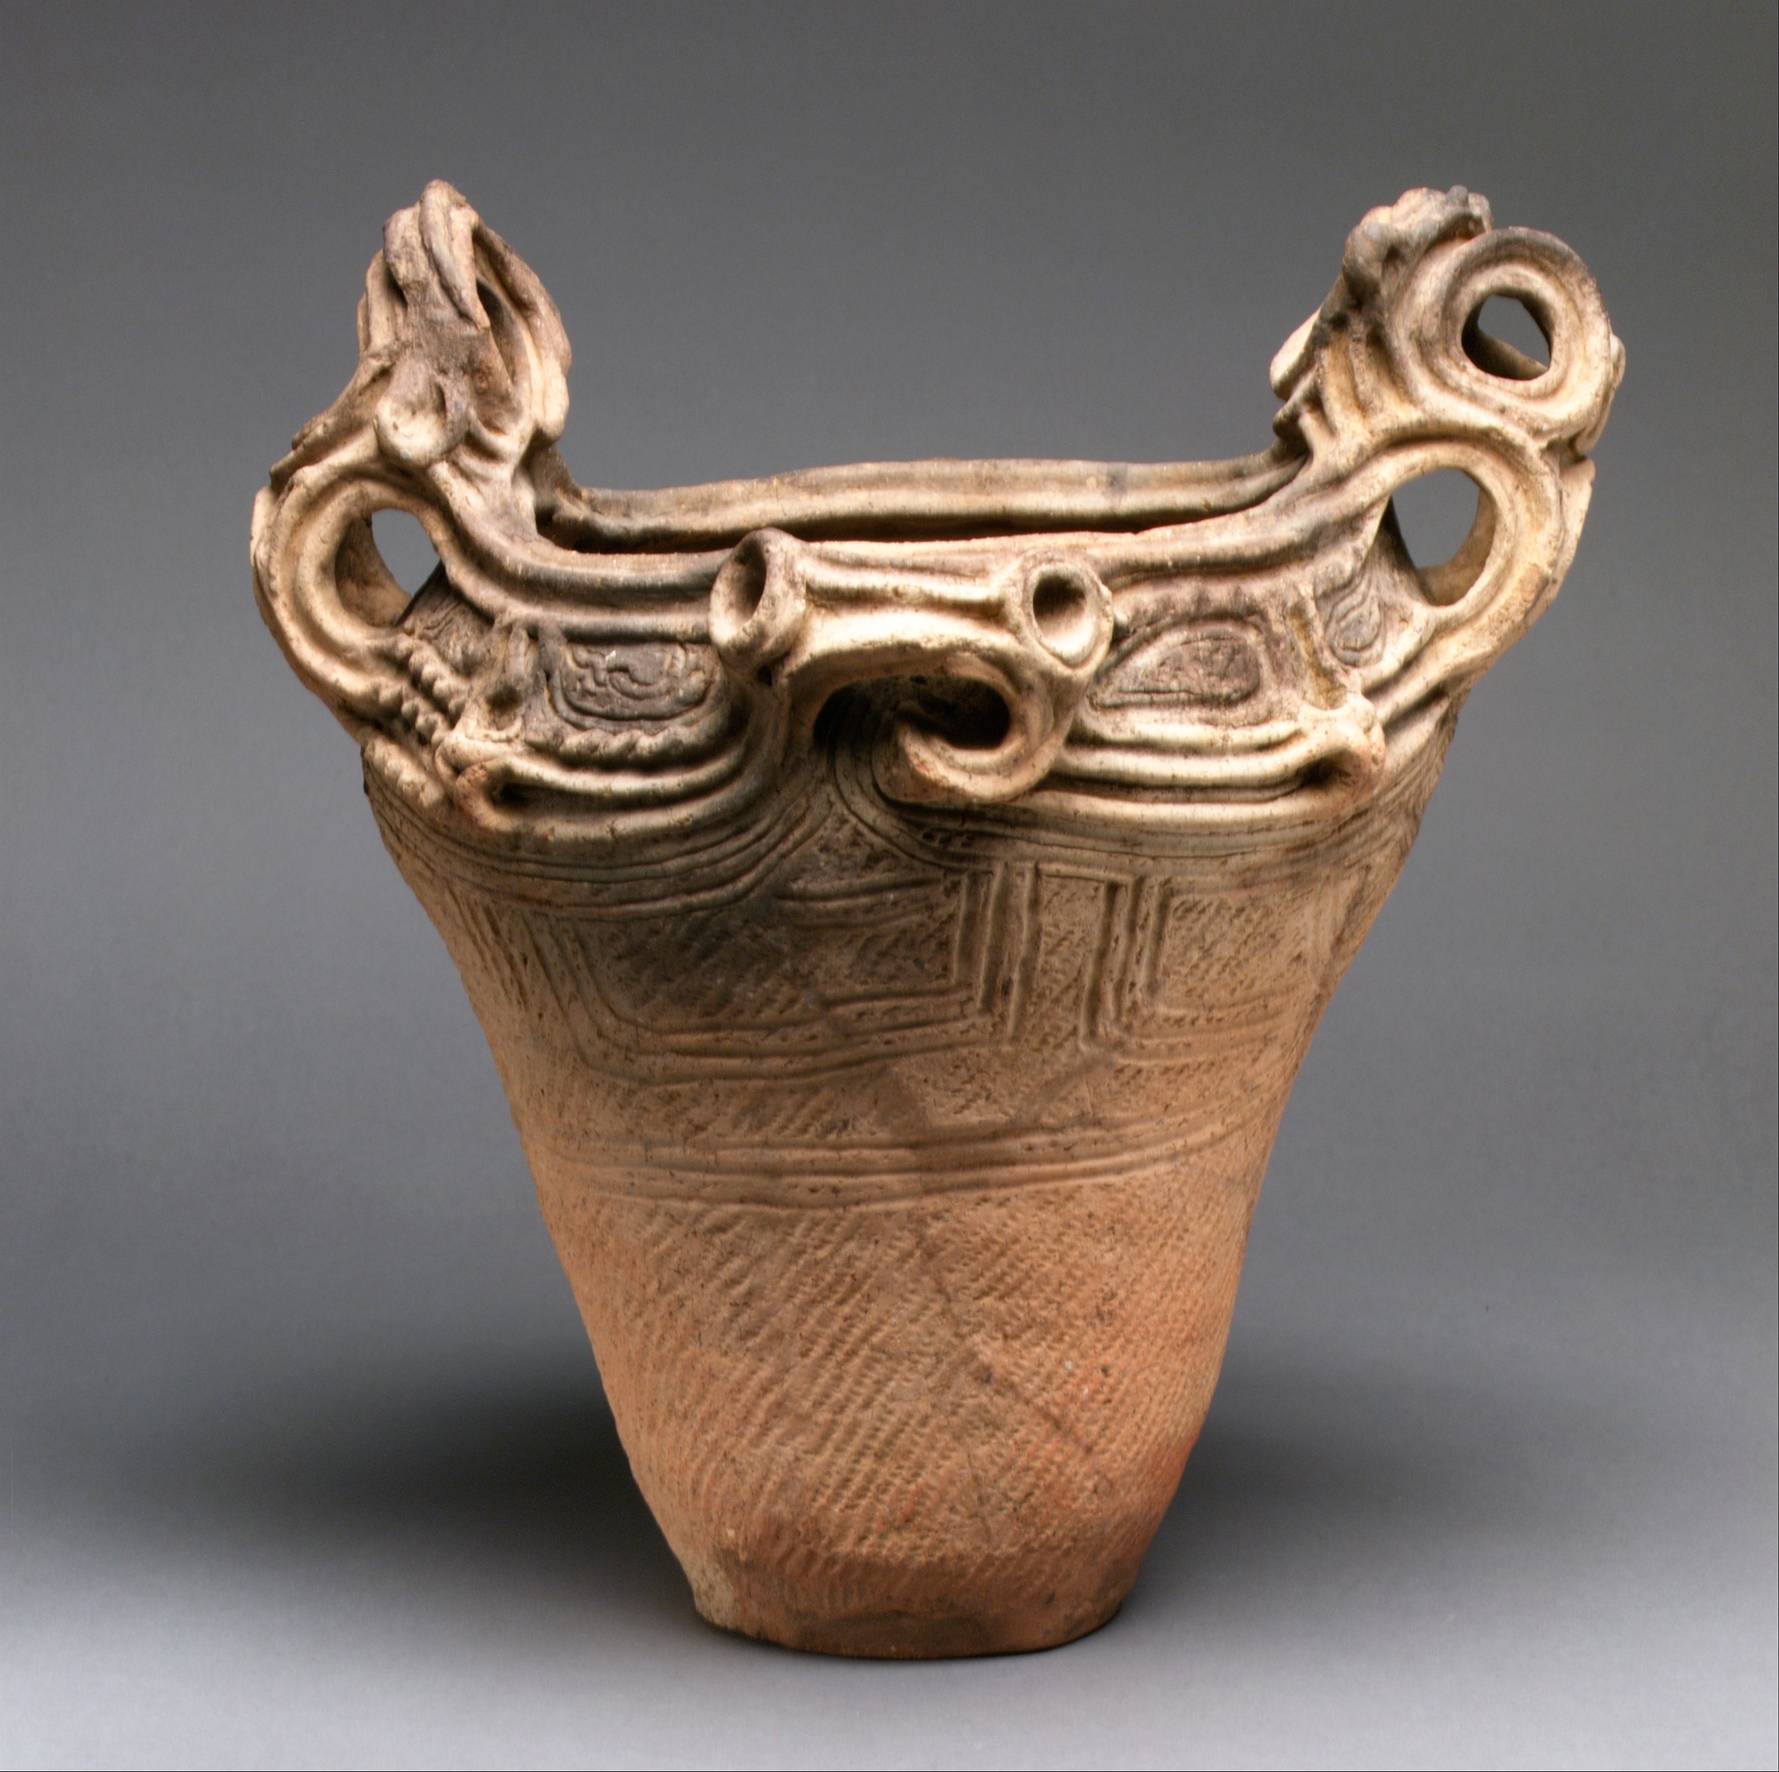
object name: bowl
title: “Flame-rimmed” deep bowl (kaen doki)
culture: japanese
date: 3500-2500 BCE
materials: cord, earthenware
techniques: incising